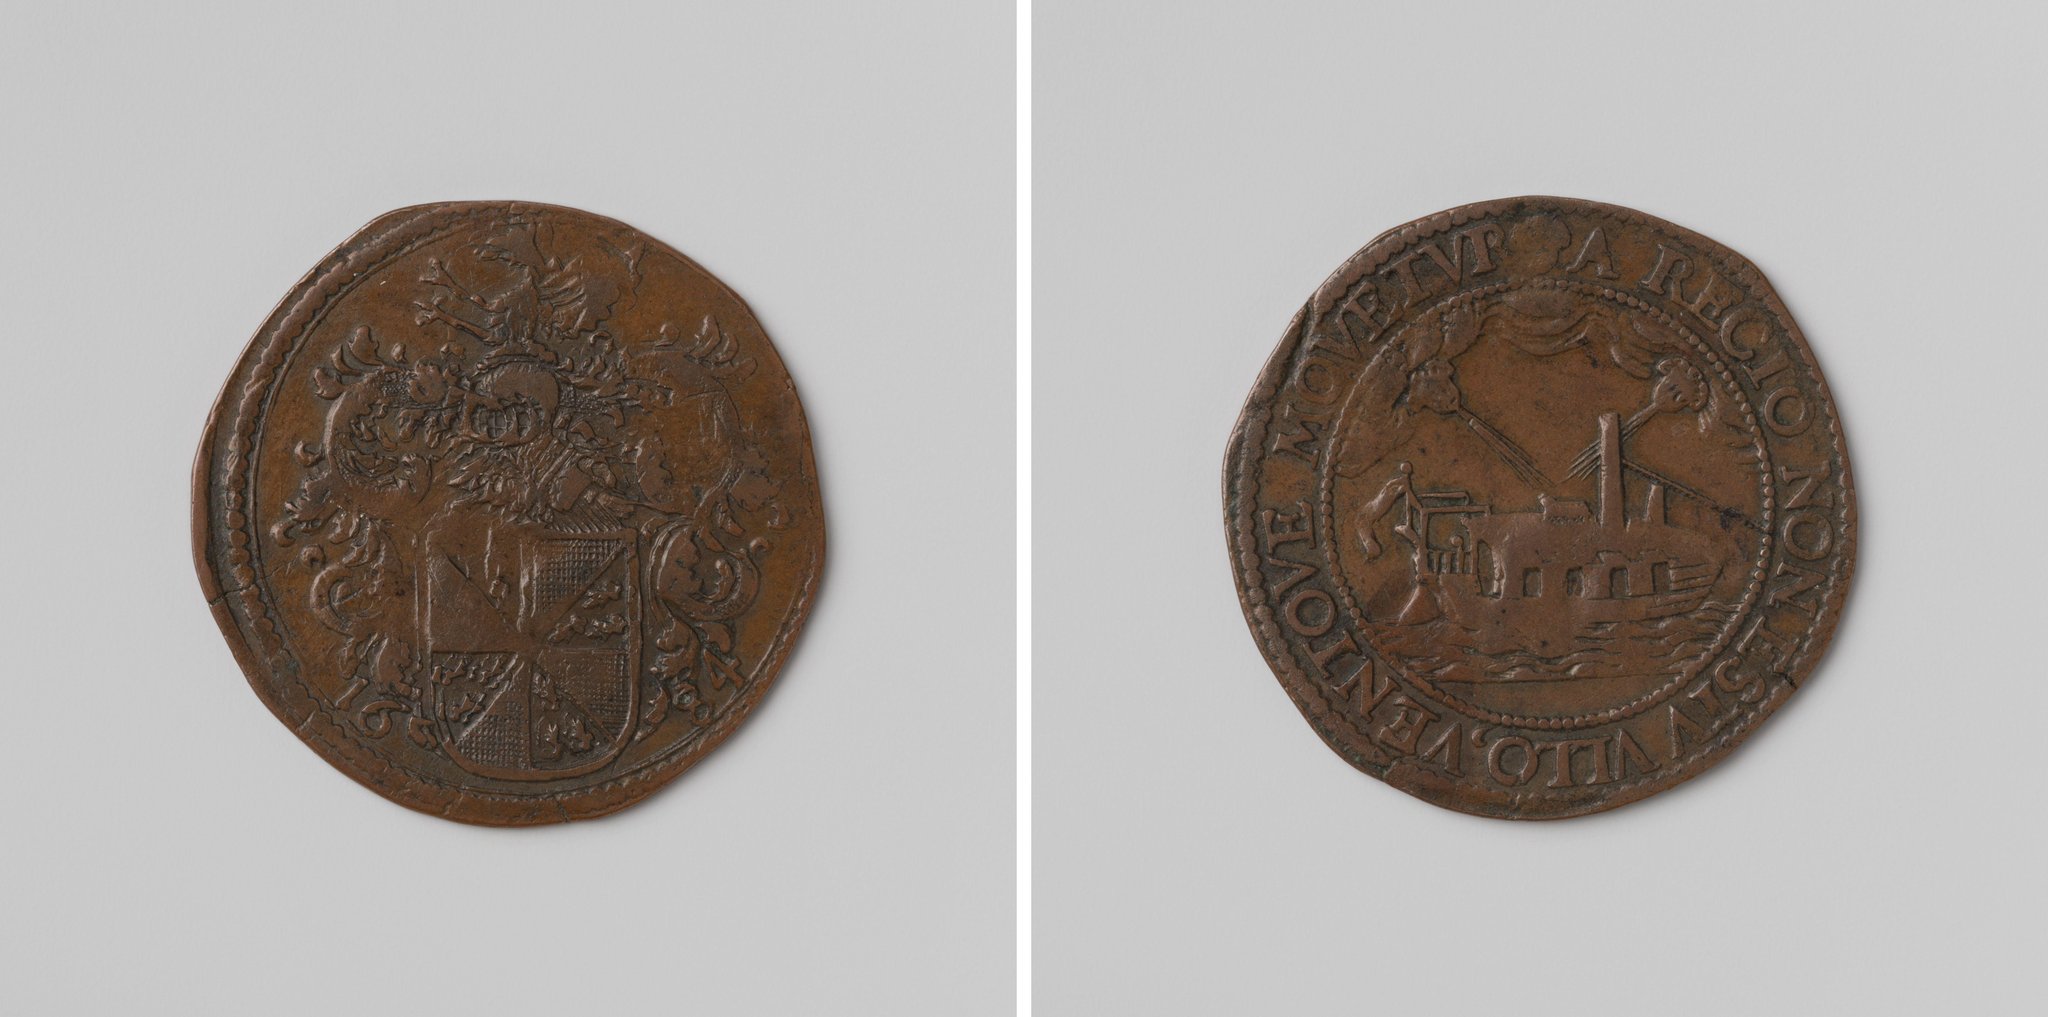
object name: jeton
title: George Ignace Van Eesbeke, bijgenaamd Vander Haegen, drieenvijftigste intendant van de vaart van Brussel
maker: Anonymous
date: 1684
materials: copper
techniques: striking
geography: brussels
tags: george ignace van eesbeke, willebroekse vaart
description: Koperen penning. Voorzijde: gehelmd wapenschild boven jaartal. Keerzijde: veer dat door wind bestookt wordt binnen omschrift